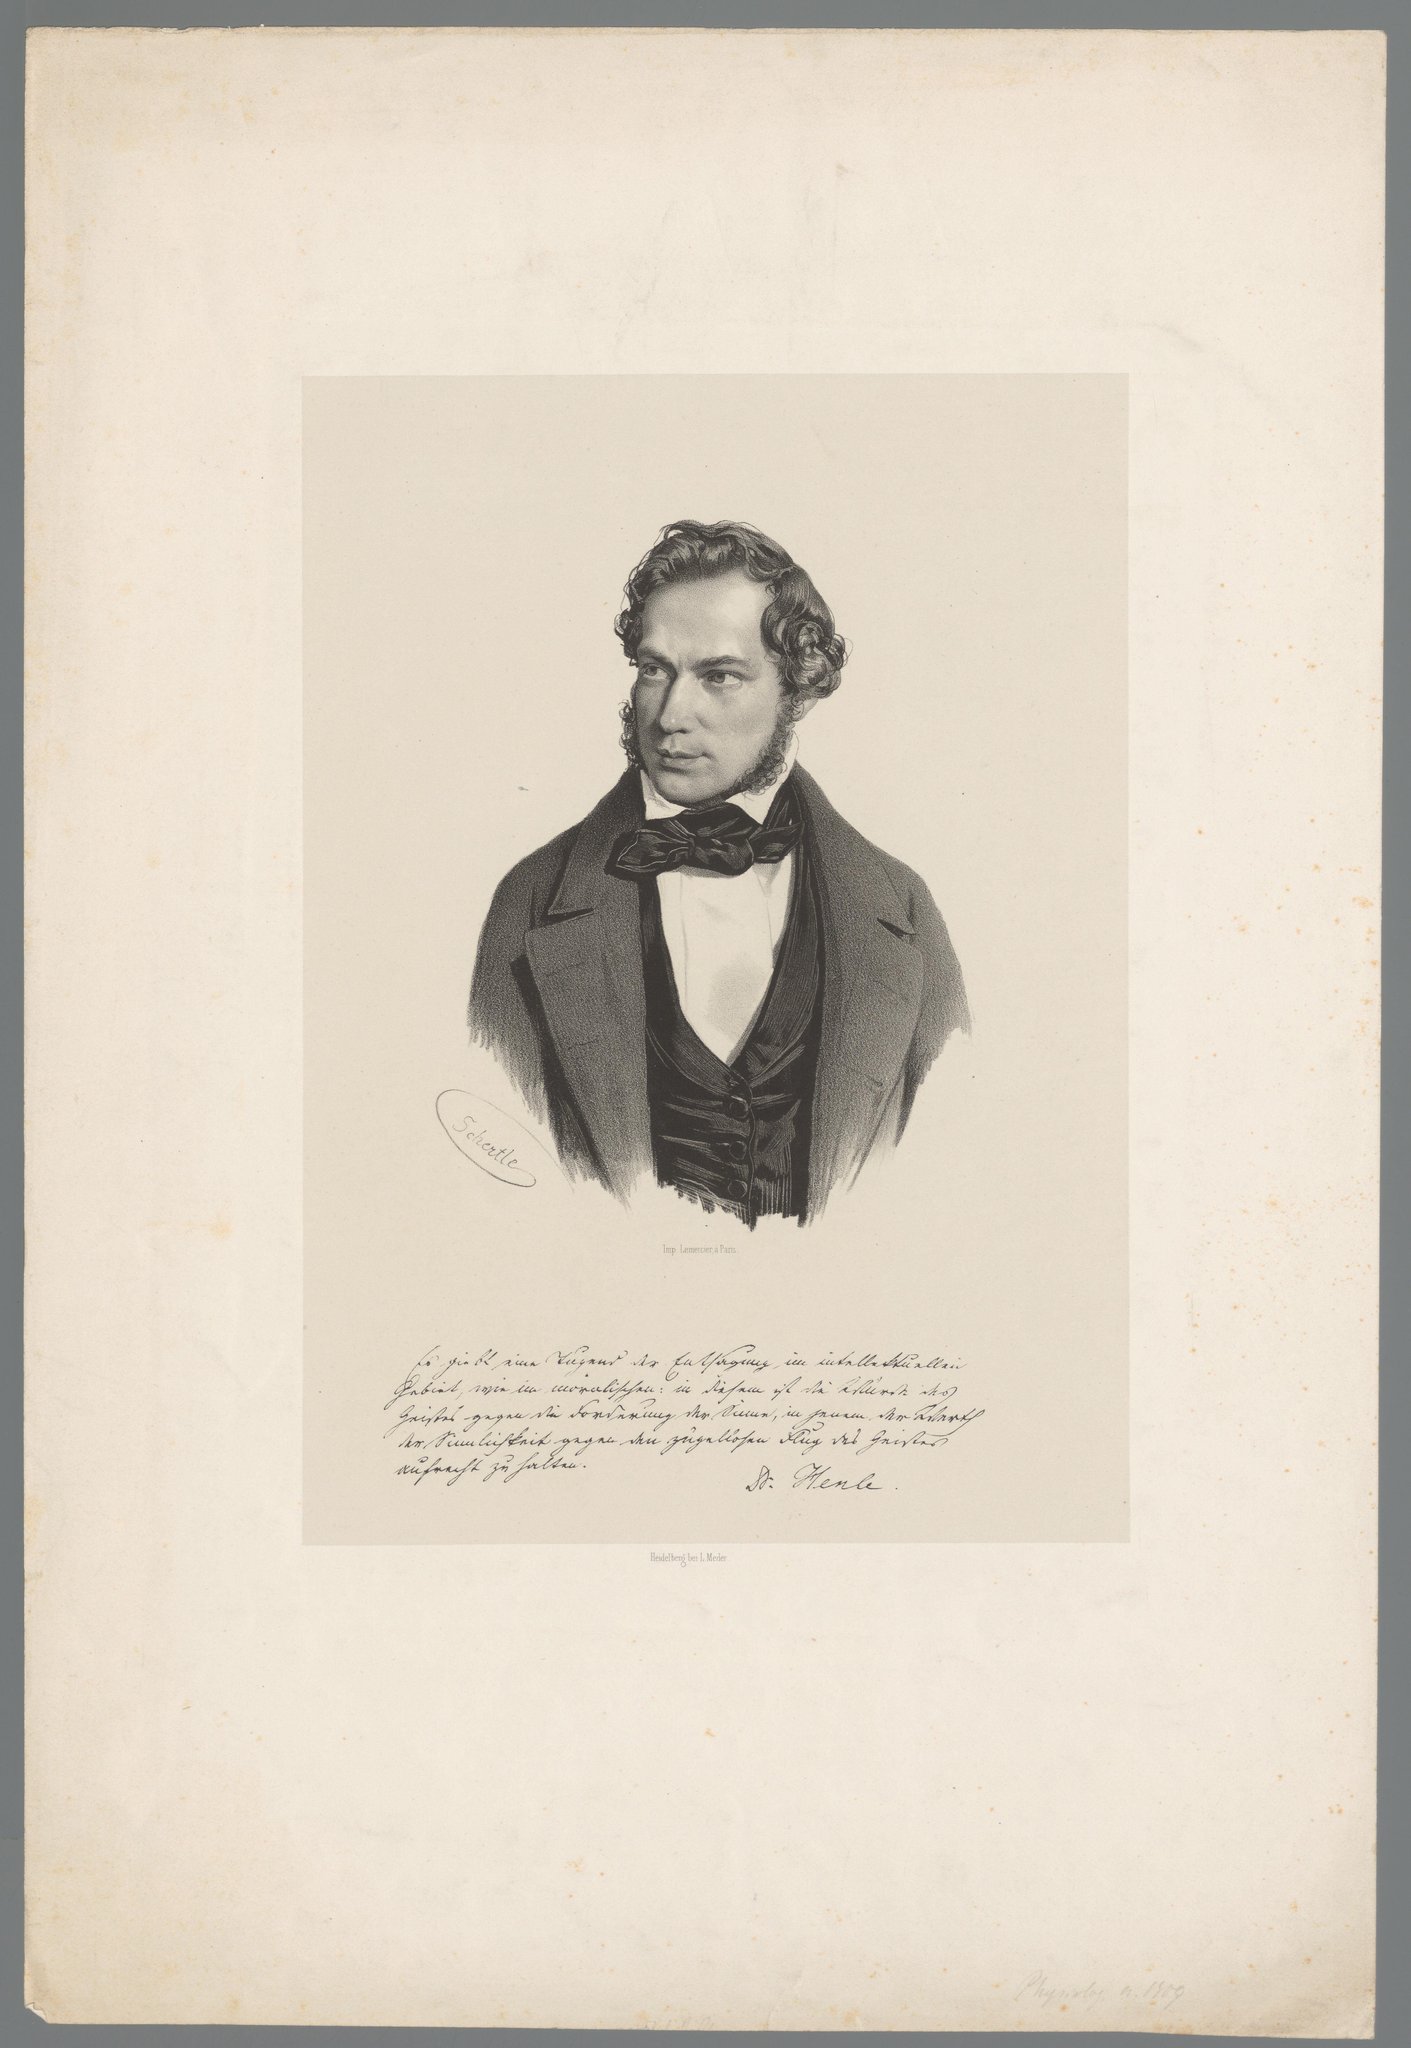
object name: print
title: Portret van Friedrich Gustav Jakob Henle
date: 1819-1885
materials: paper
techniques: lithograph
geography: heidelberg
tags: adult man, historical persons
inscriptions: collector's mark: Lugt 2228